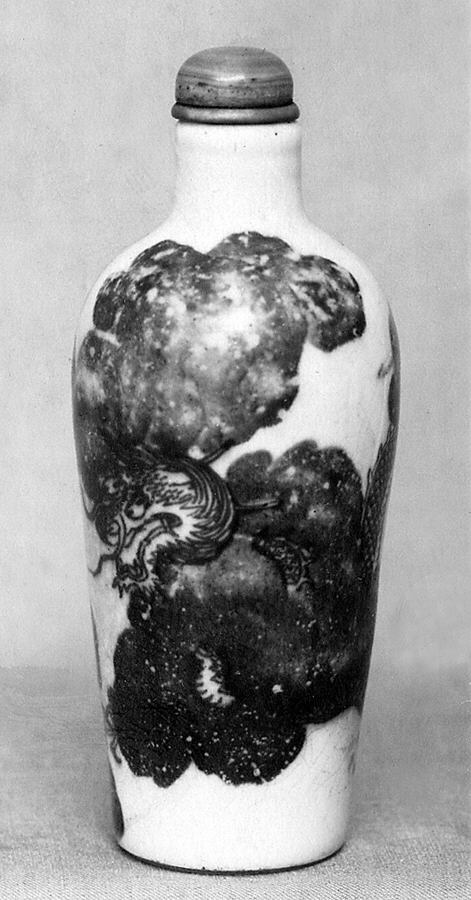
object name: snuff bottle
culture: chinese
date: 1723-1735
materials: porcelain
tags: dragons